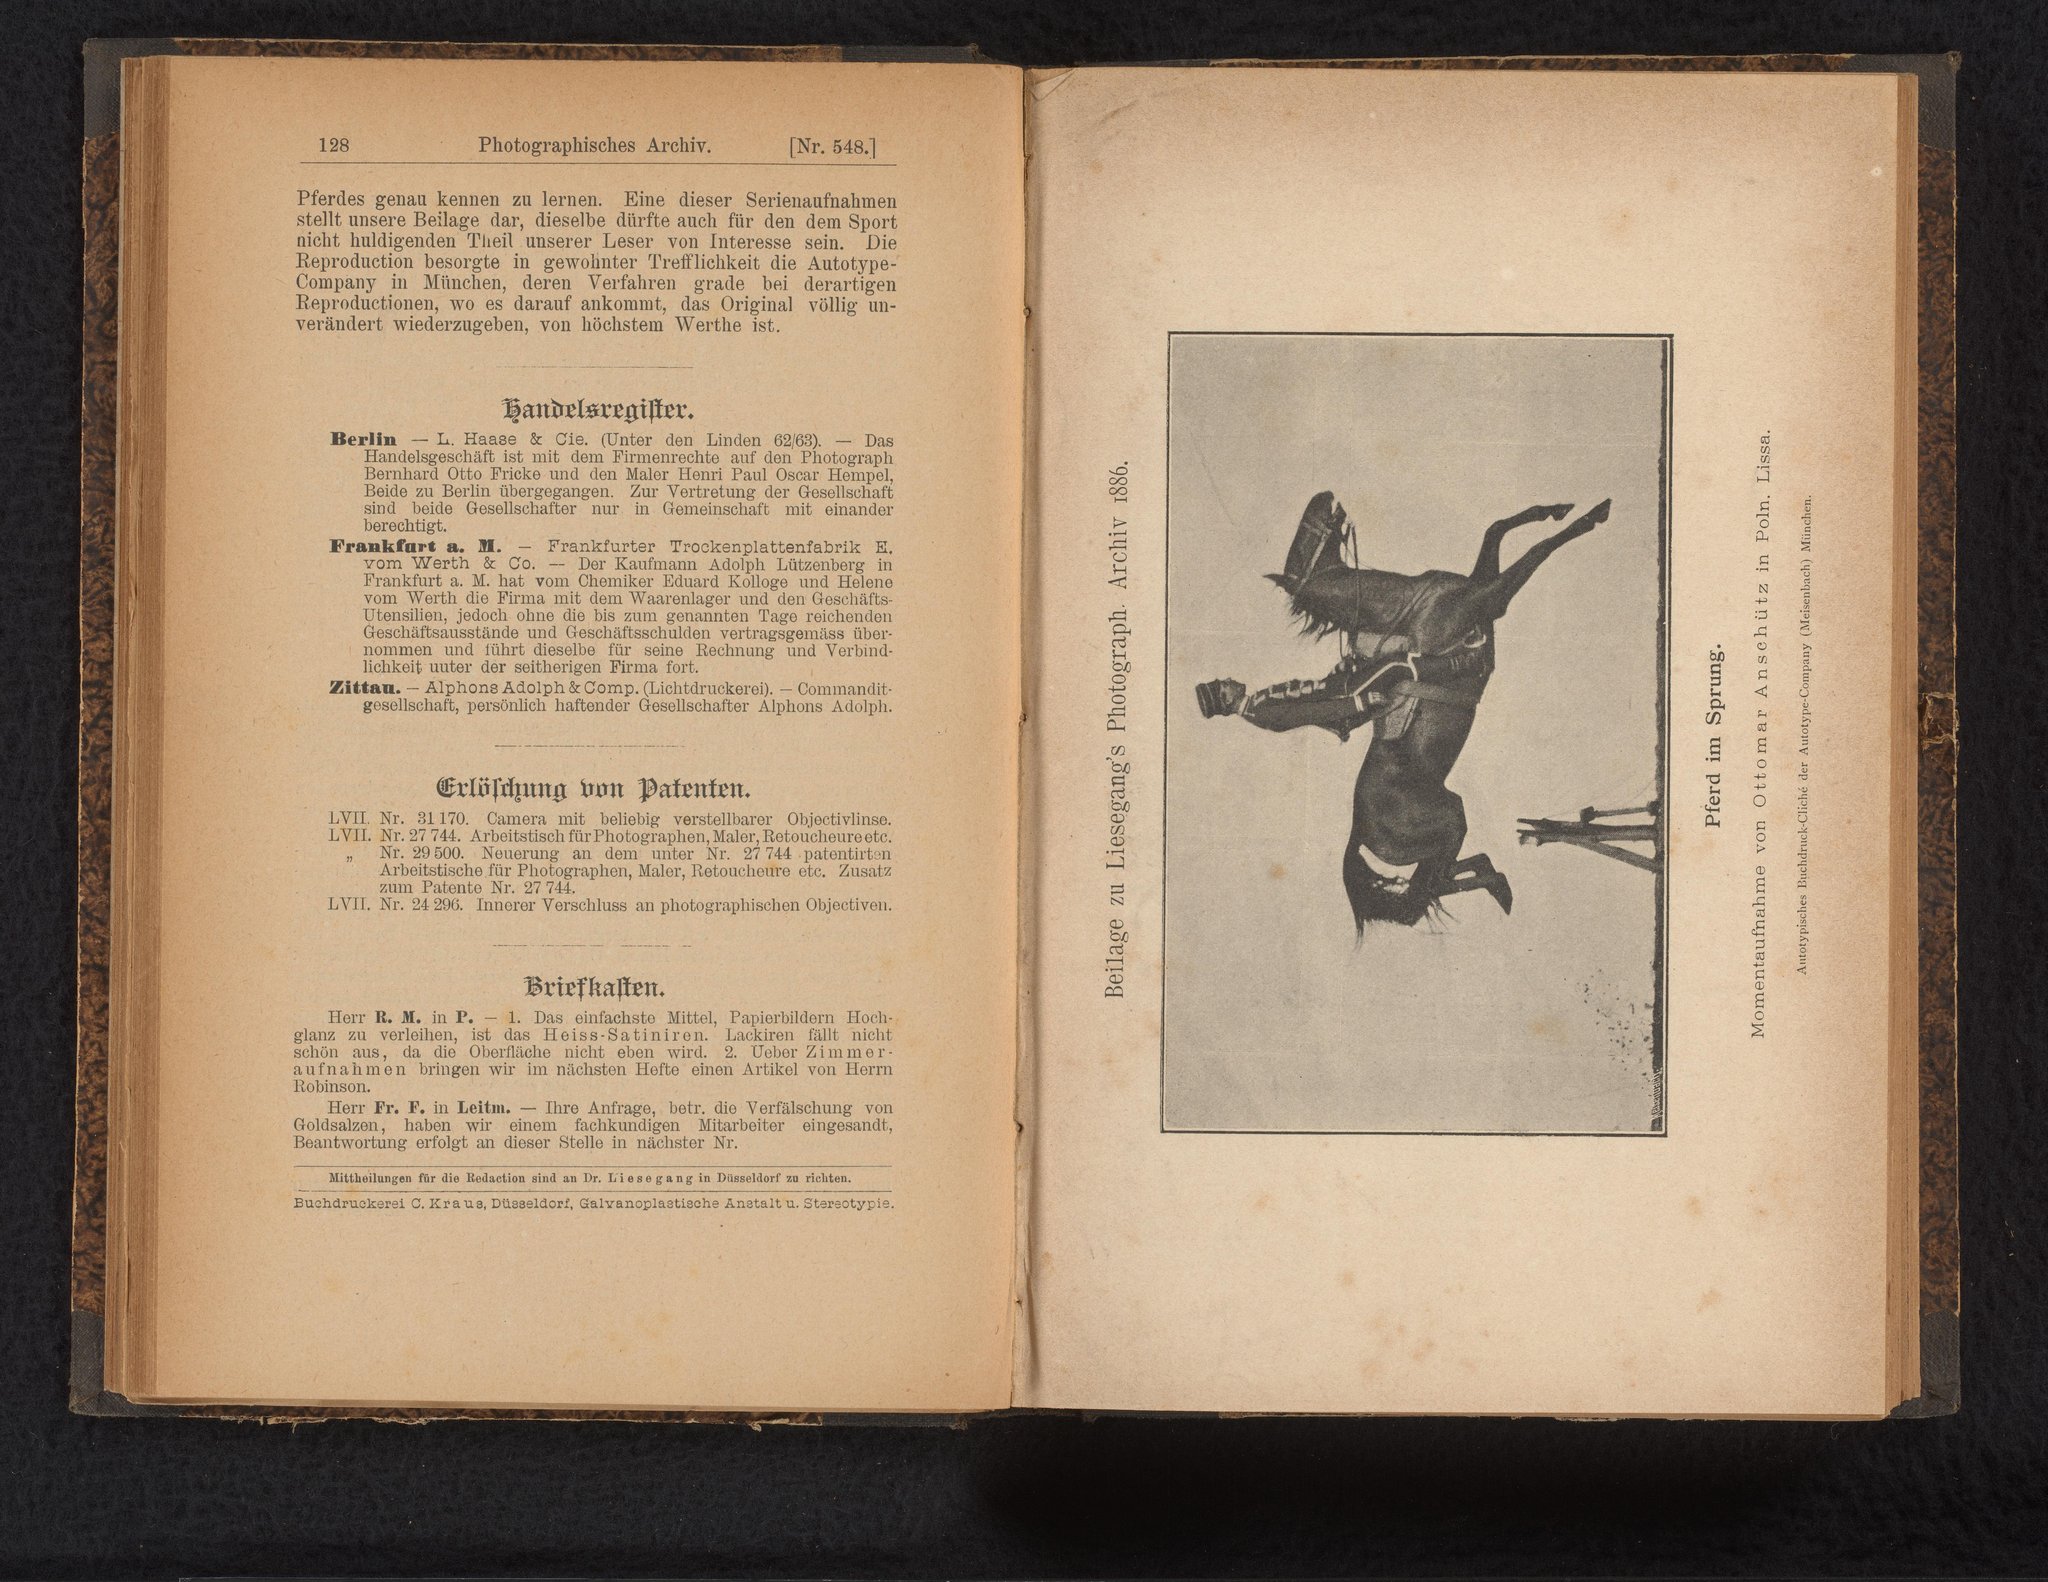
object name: page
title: Springend paard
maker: ottomar anschütz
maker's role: fotograaf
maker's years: 1846-1907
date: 1881-1886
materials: paper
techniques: autotype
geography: leszno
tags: jumping (horse in motion)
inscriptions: signature: ‘Meisenbach’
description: Prent op ongenummerde pagina tegenover pagina 128.